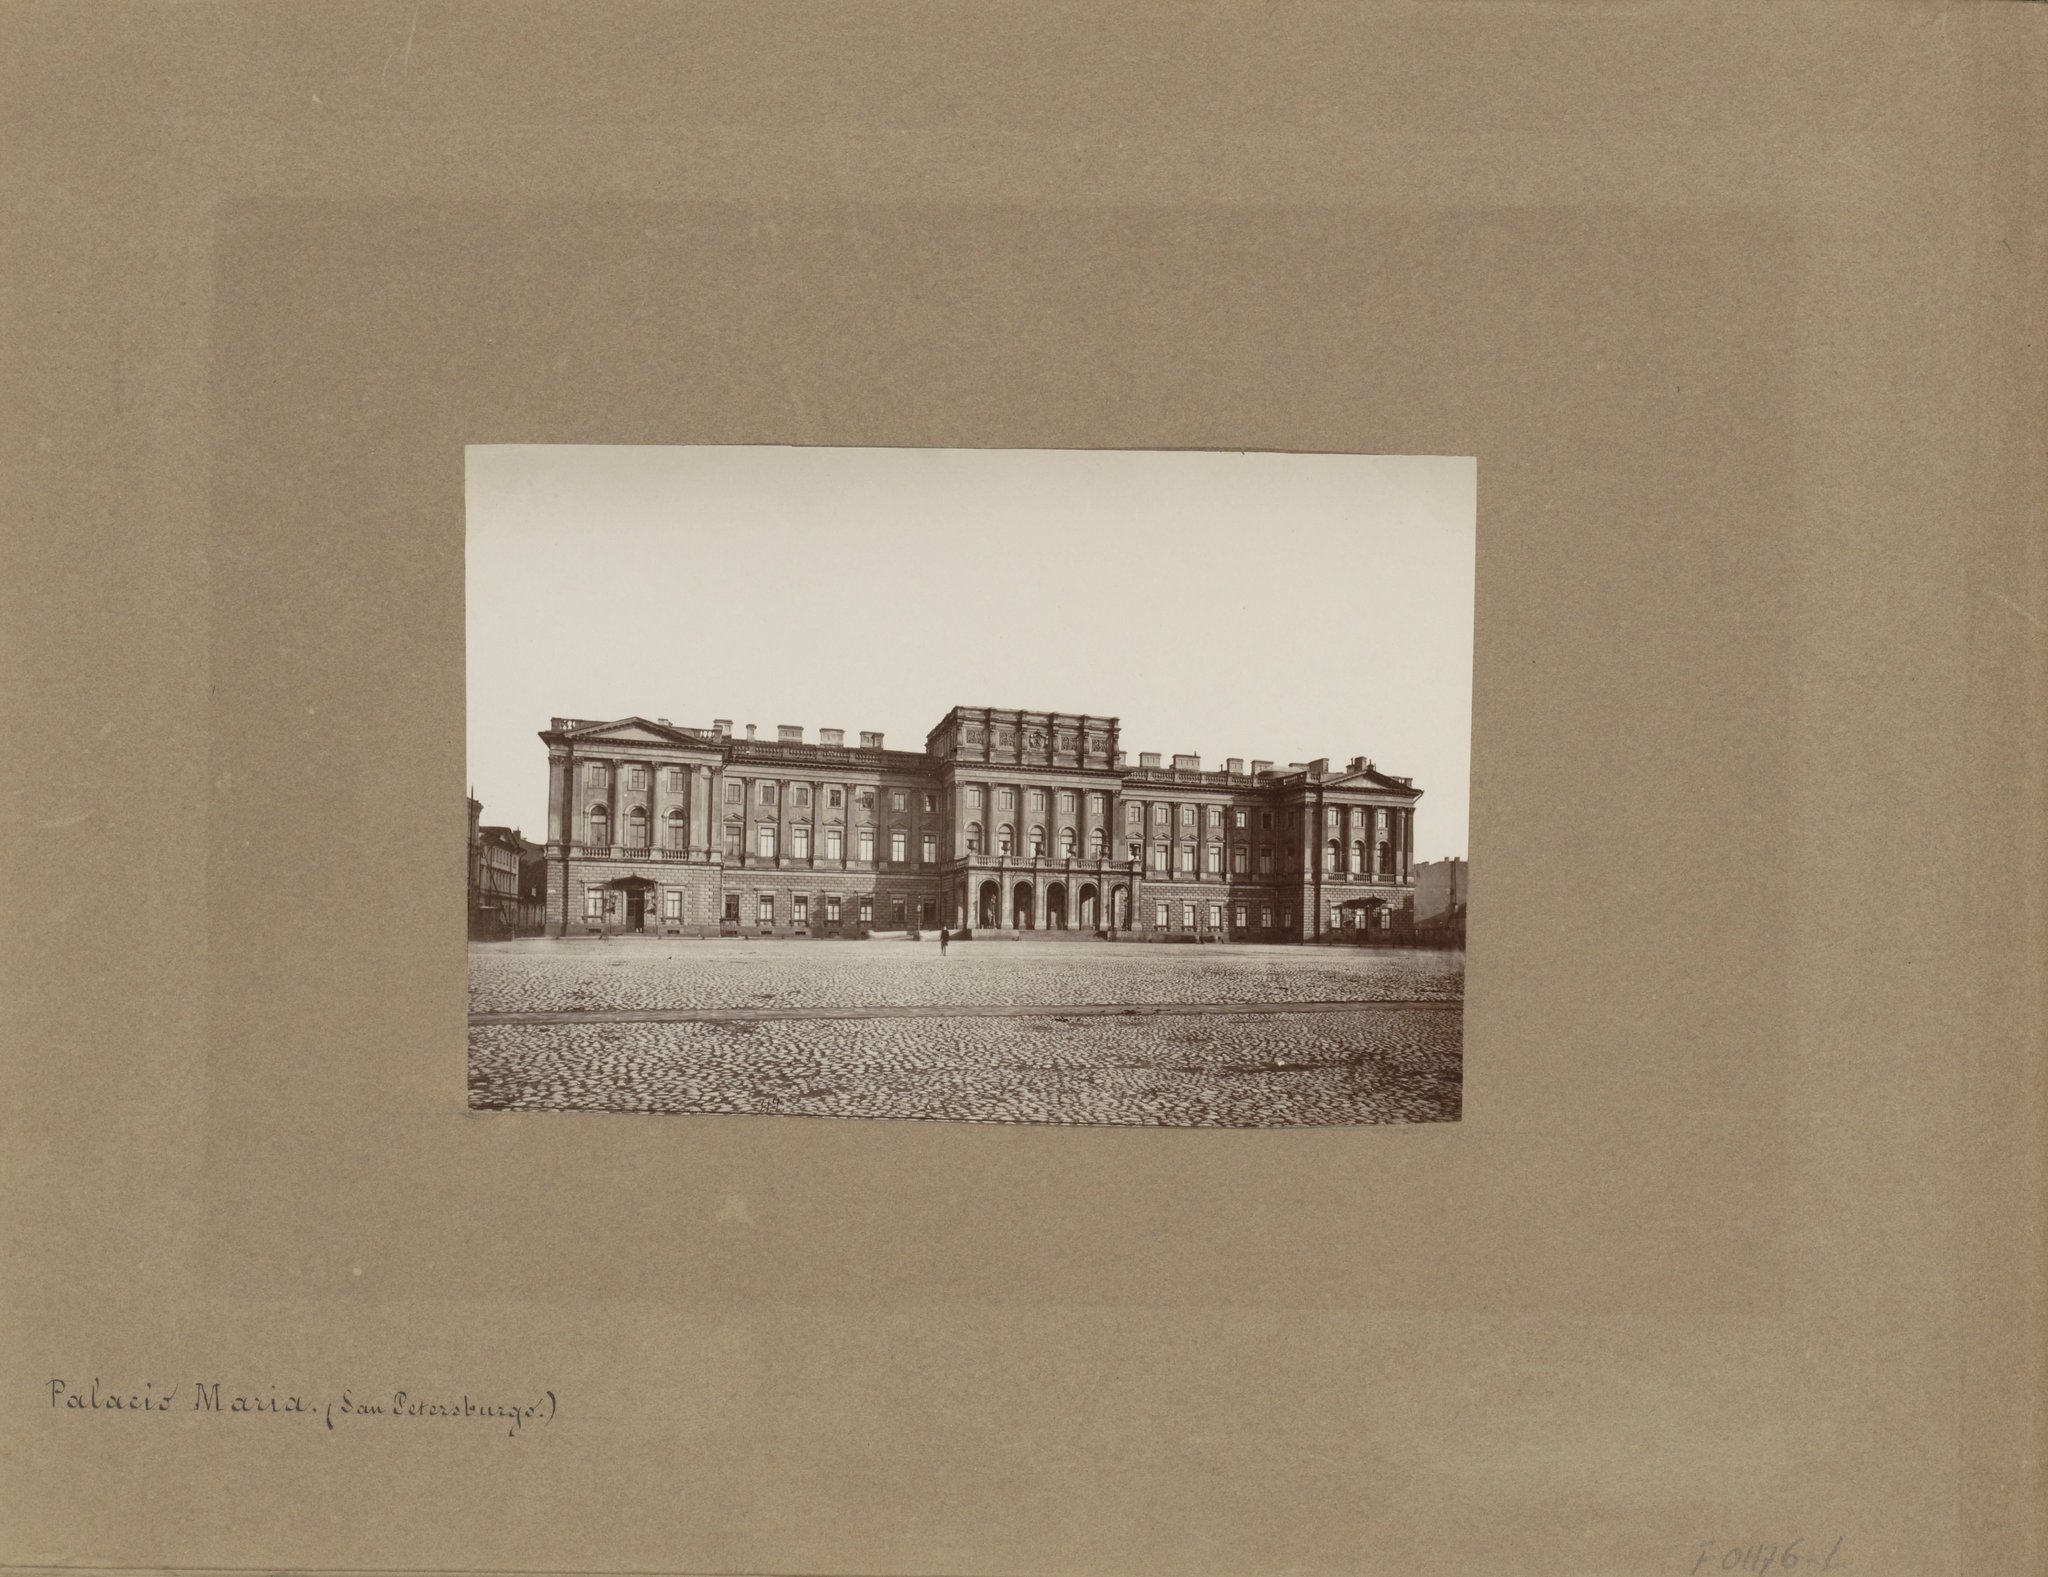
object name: photograph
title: Palacio Maria. (San Petersburgo.)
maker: alfred lorens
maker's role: fotograaf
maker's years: 1830-1896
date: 1850-1876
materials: photographic support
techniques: albumen print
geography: sint-petersburg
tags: palace, travelling; tourism, square, place, circus, etc. (+ city(-scape) with figures, staffage)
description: Onderdeel van Reisalbum met foto's en tekeningen van Manuel Mayo 1876.